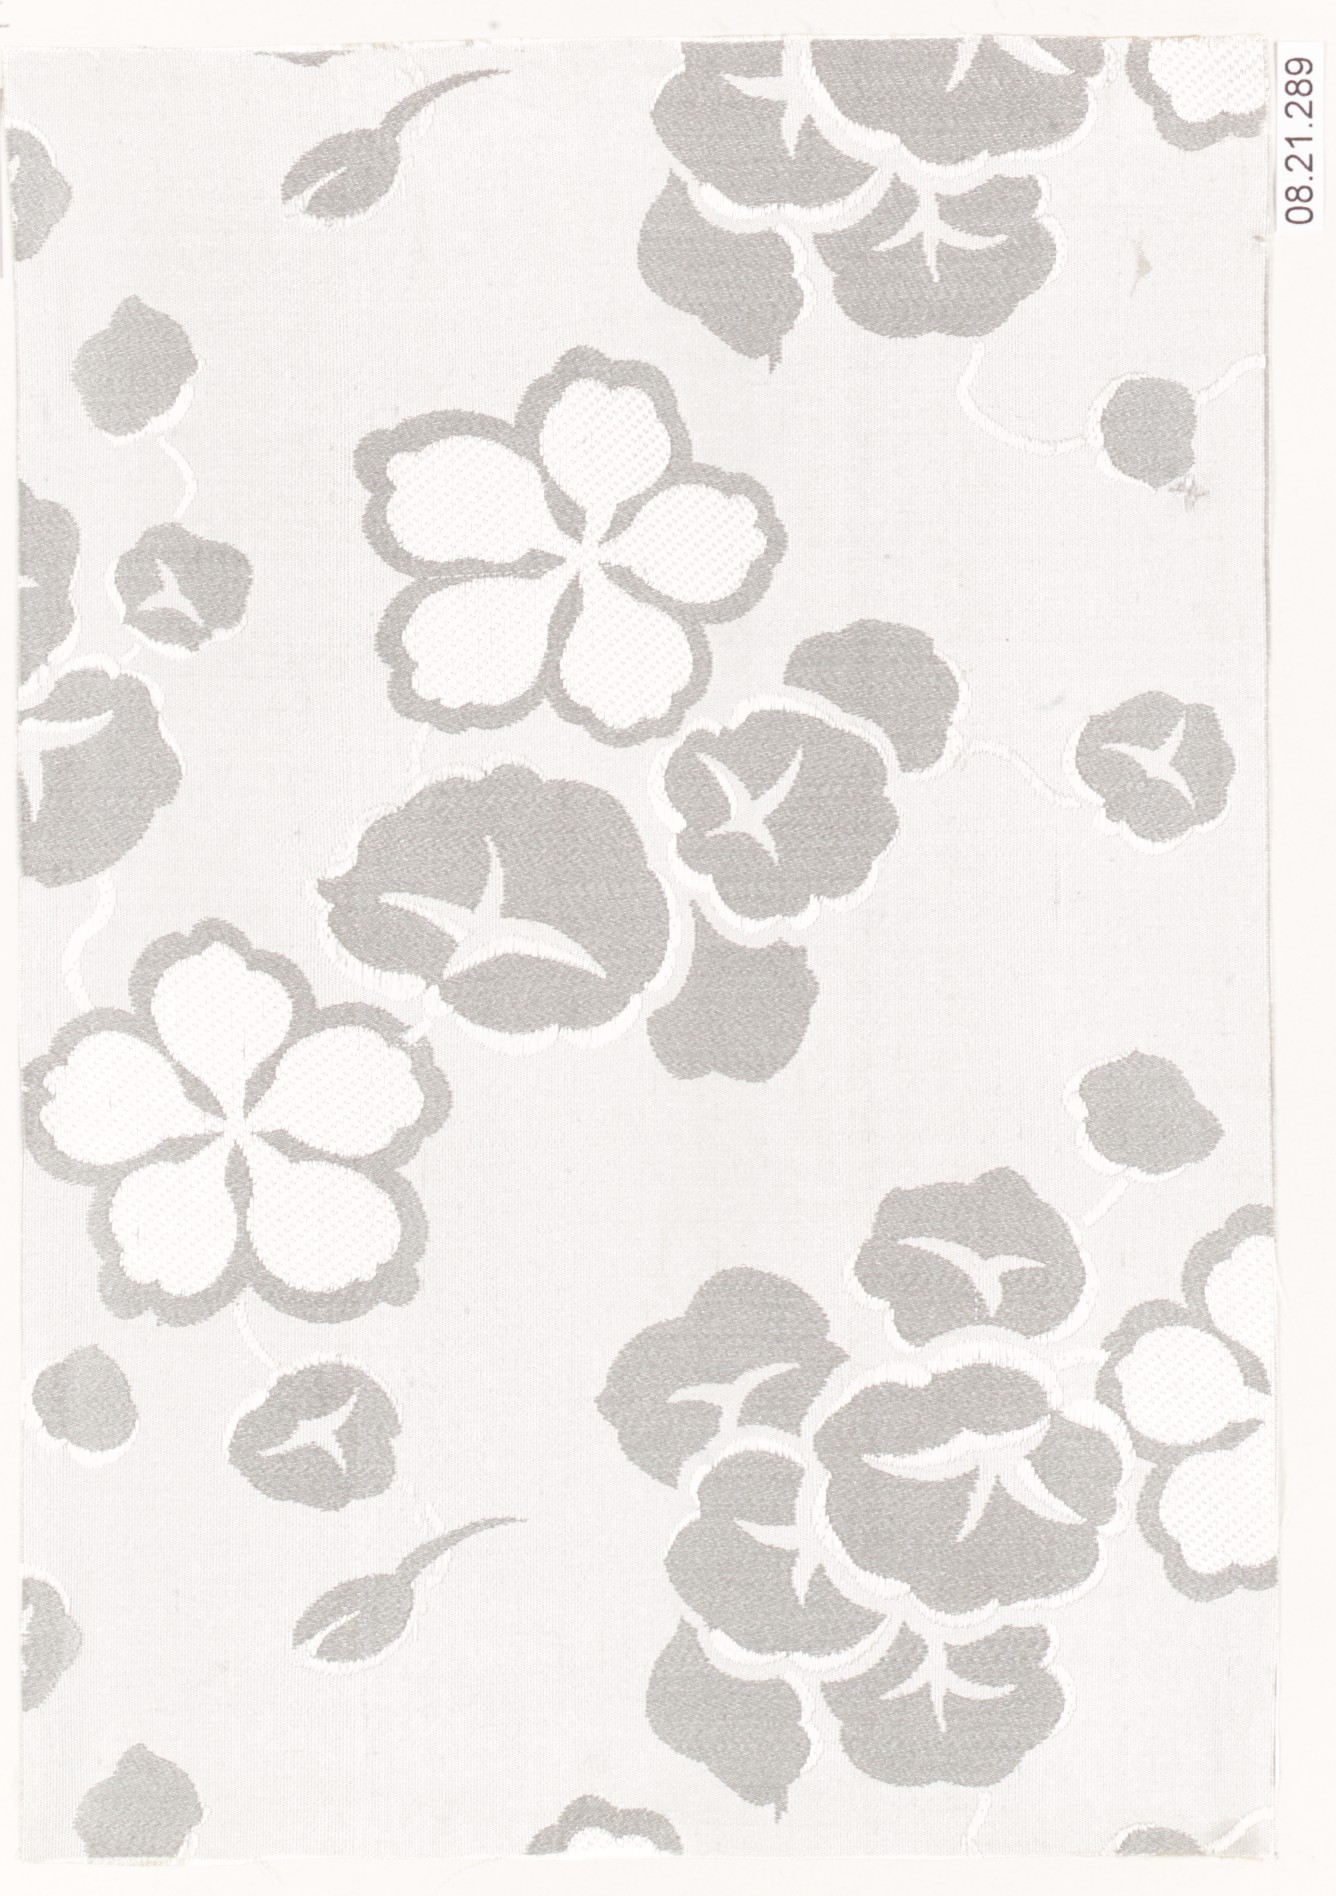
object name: textile sample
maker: Anonymous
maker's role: designer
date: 1900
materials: silk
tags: flowers